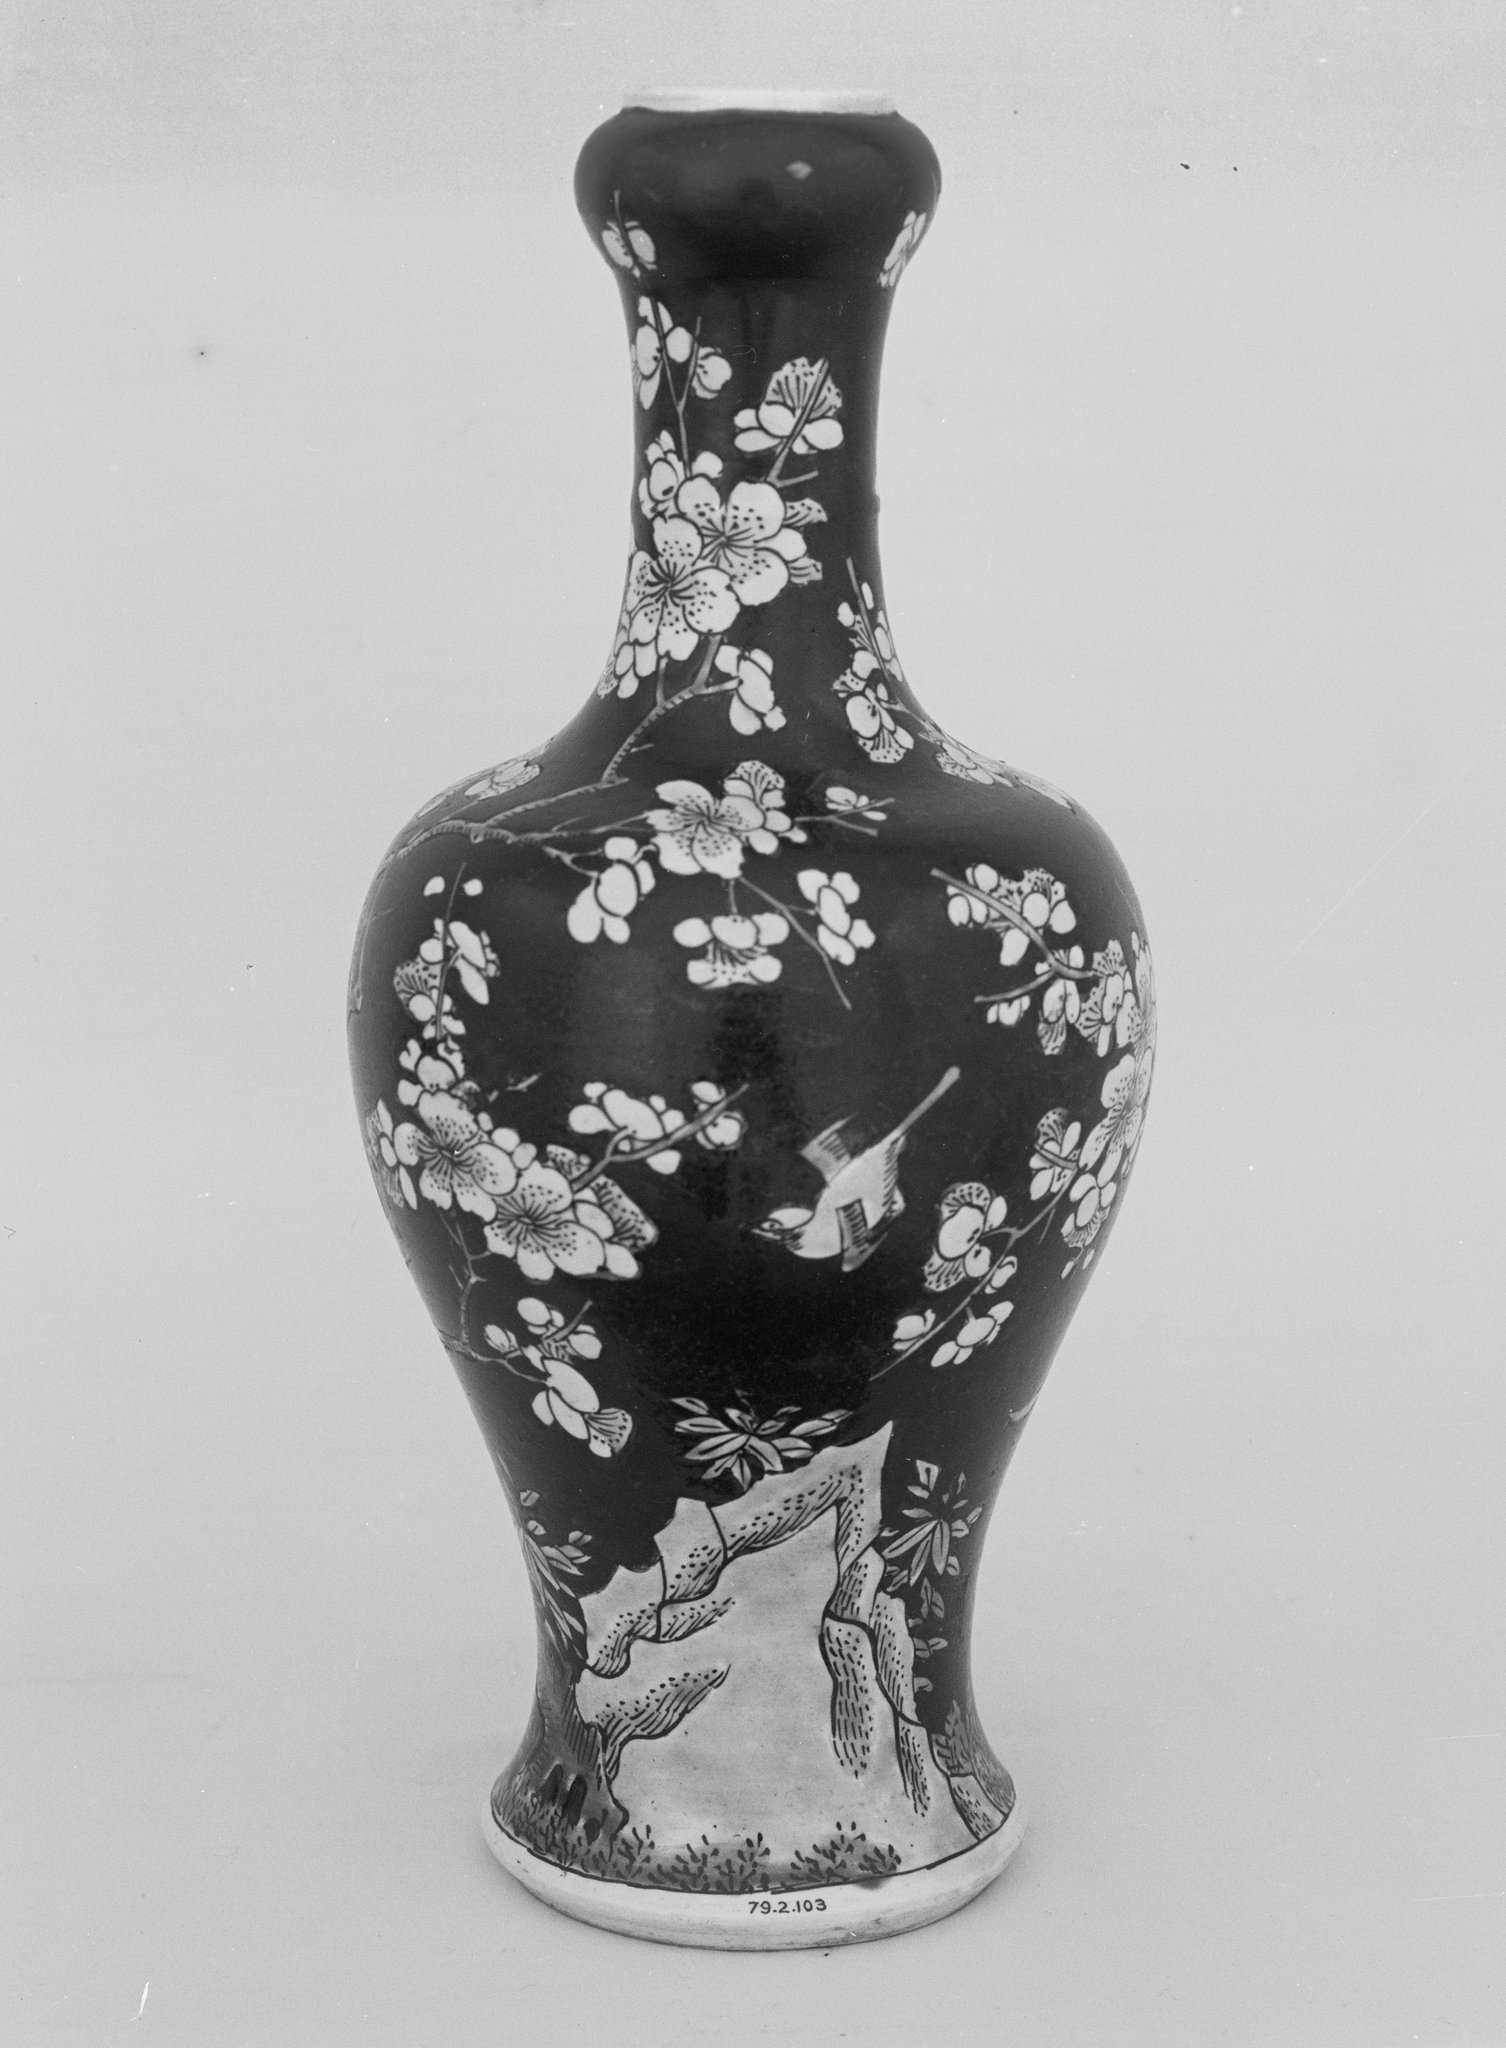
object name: vase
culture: chinese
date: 1701-1733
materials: biscuit, enamel, porcelain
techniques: painting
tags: birds,flowers